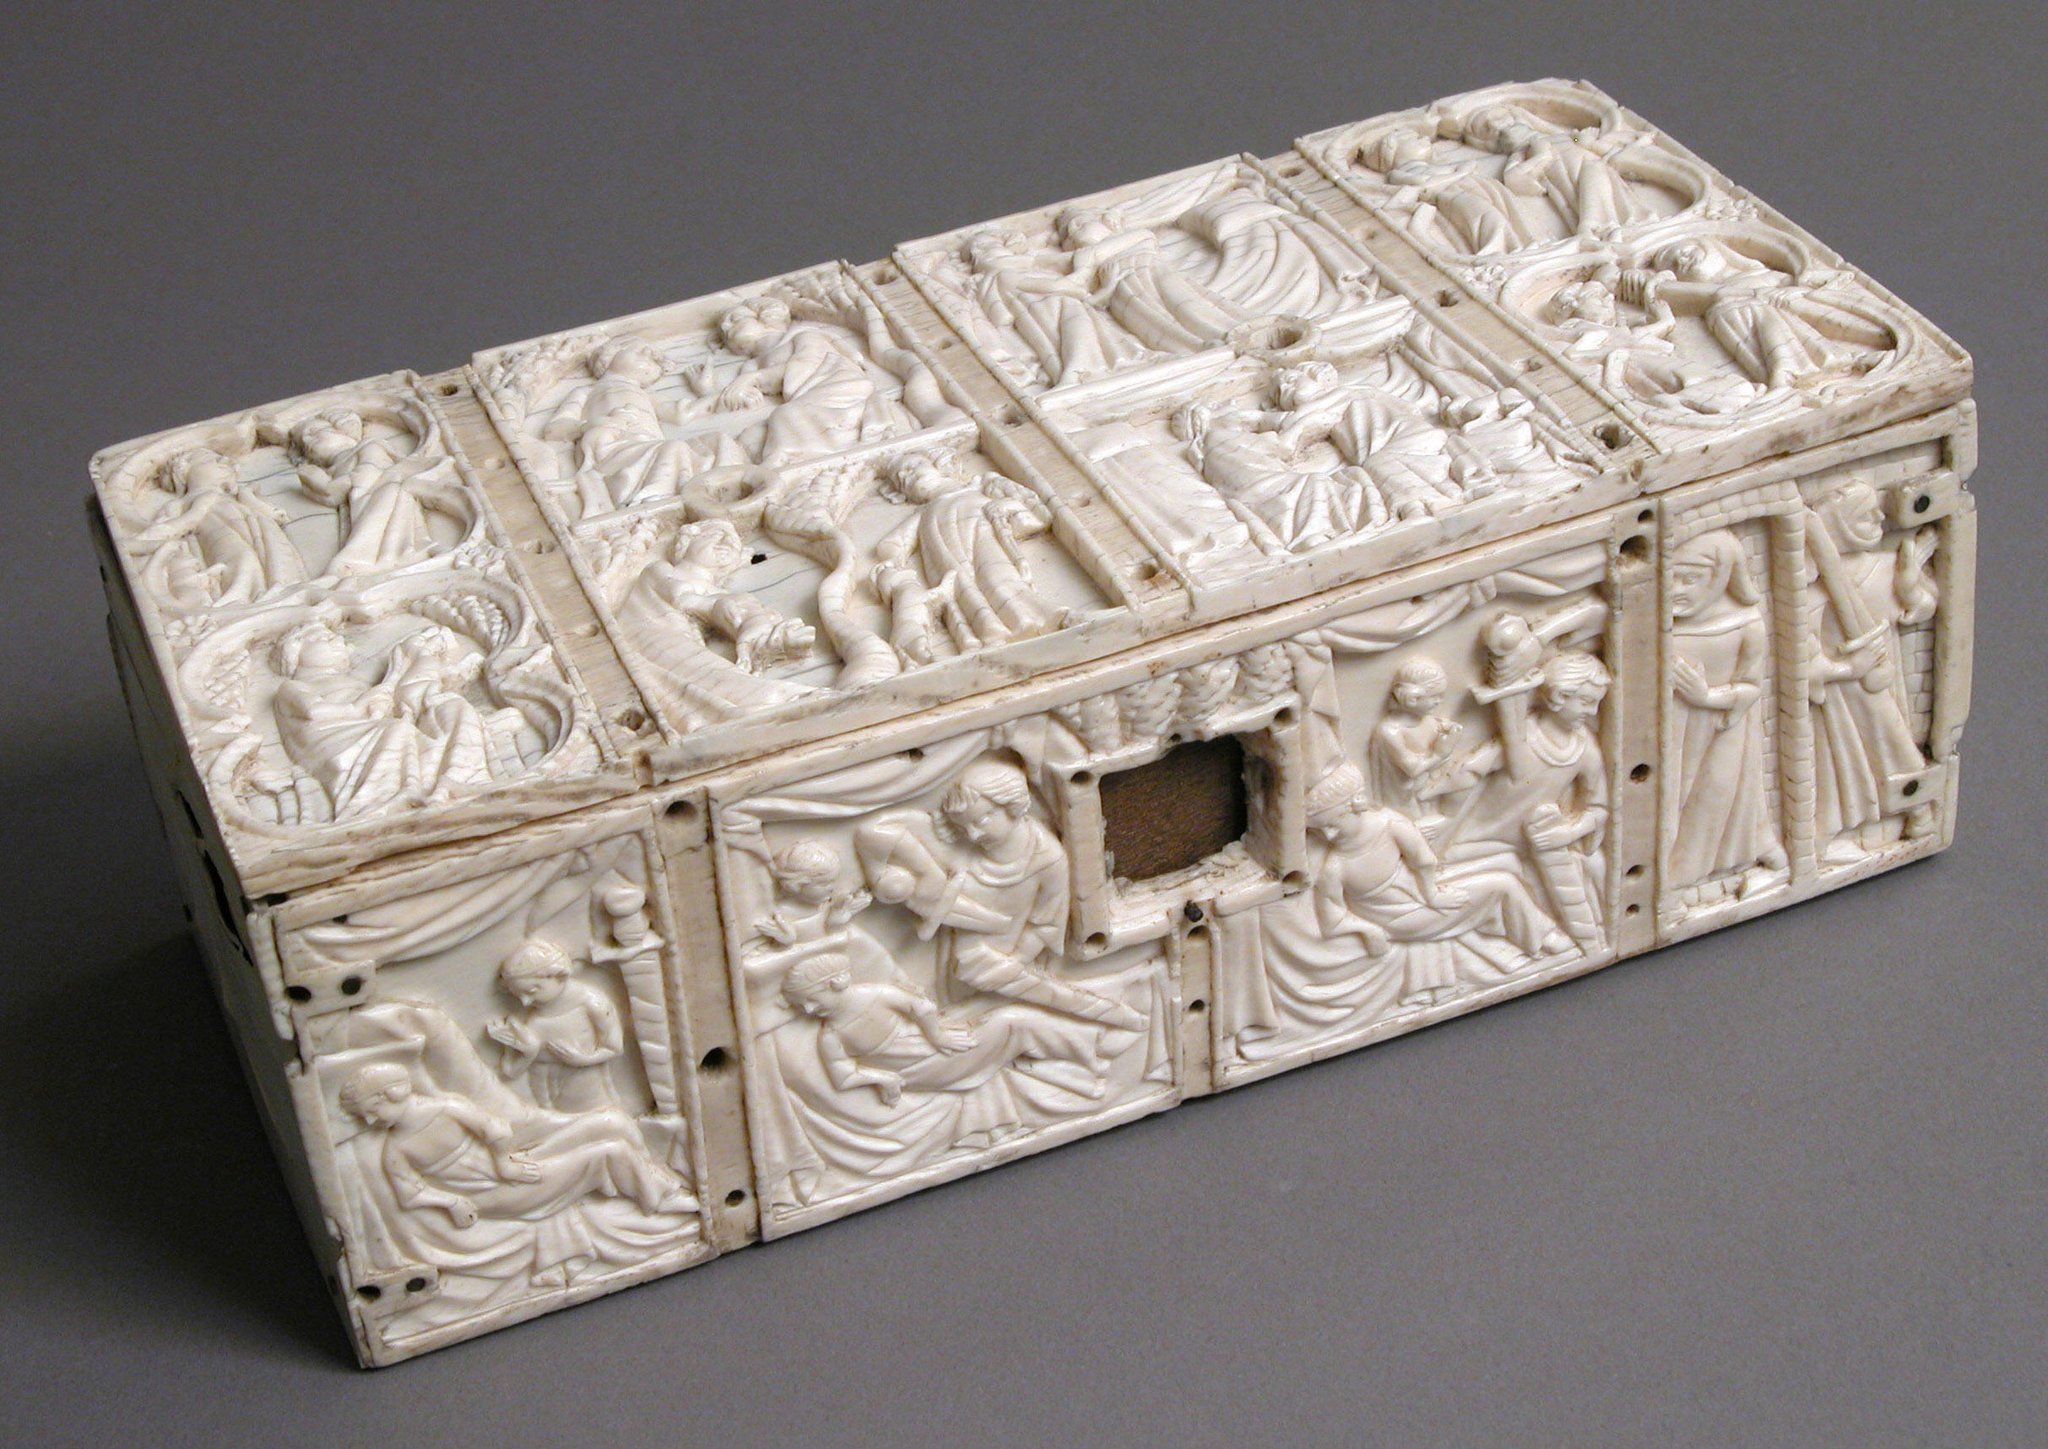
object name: box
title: Box with Scenes from the Romance, “The Chatelaine de Vergy”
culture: french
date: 1320-1340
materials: ivory, wood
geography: france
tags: weapons,couples,men,women